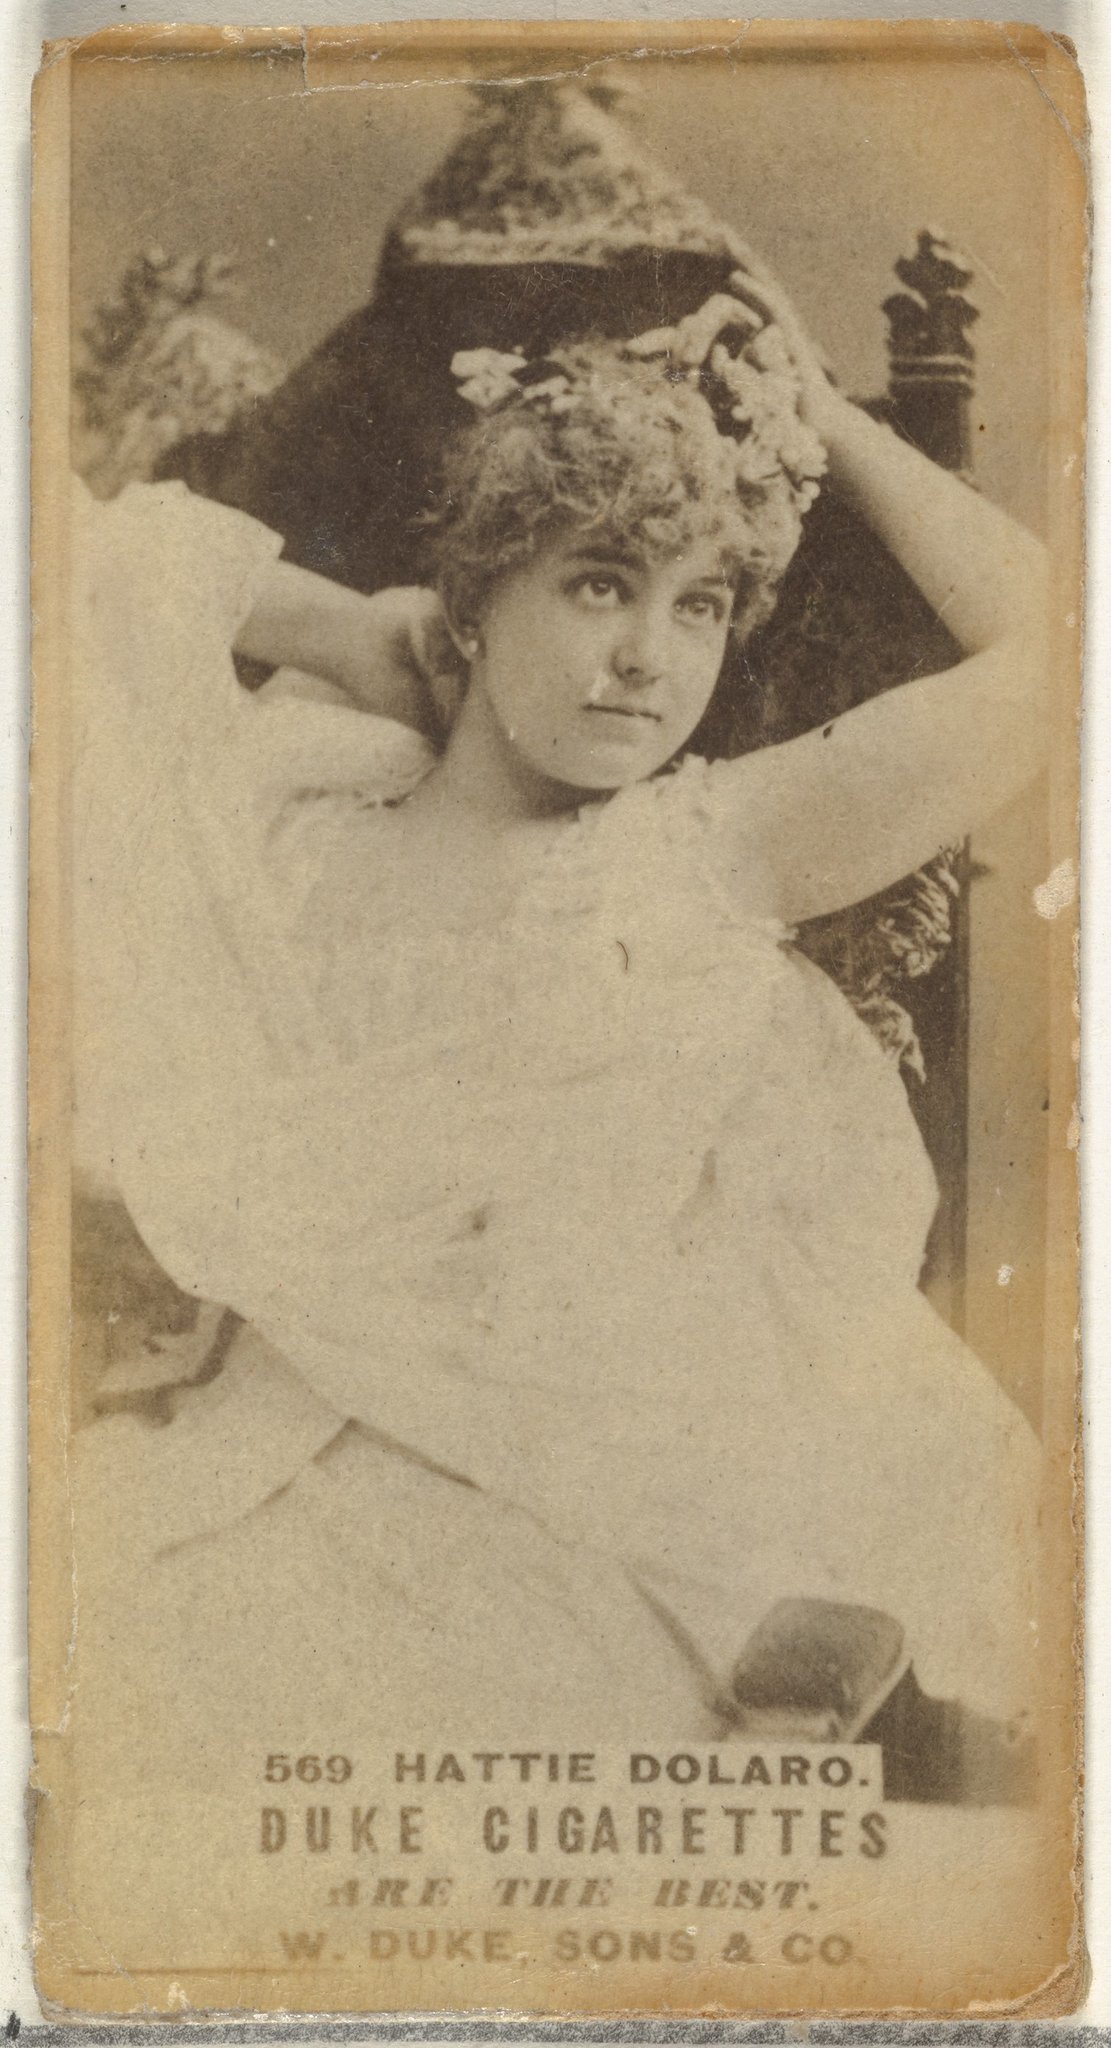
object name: photograph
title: Card Number 569, Hattie Dolaro, from the Actors and Actresses series (N145-7) issued by Duke Sons & Co. to promote Duke Cigarettes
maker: w. duke, sons & co.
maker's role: publisher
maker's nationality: american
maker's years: 1870-1920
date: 1880-1889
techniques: albumen silver print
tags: portraits,women,actresses